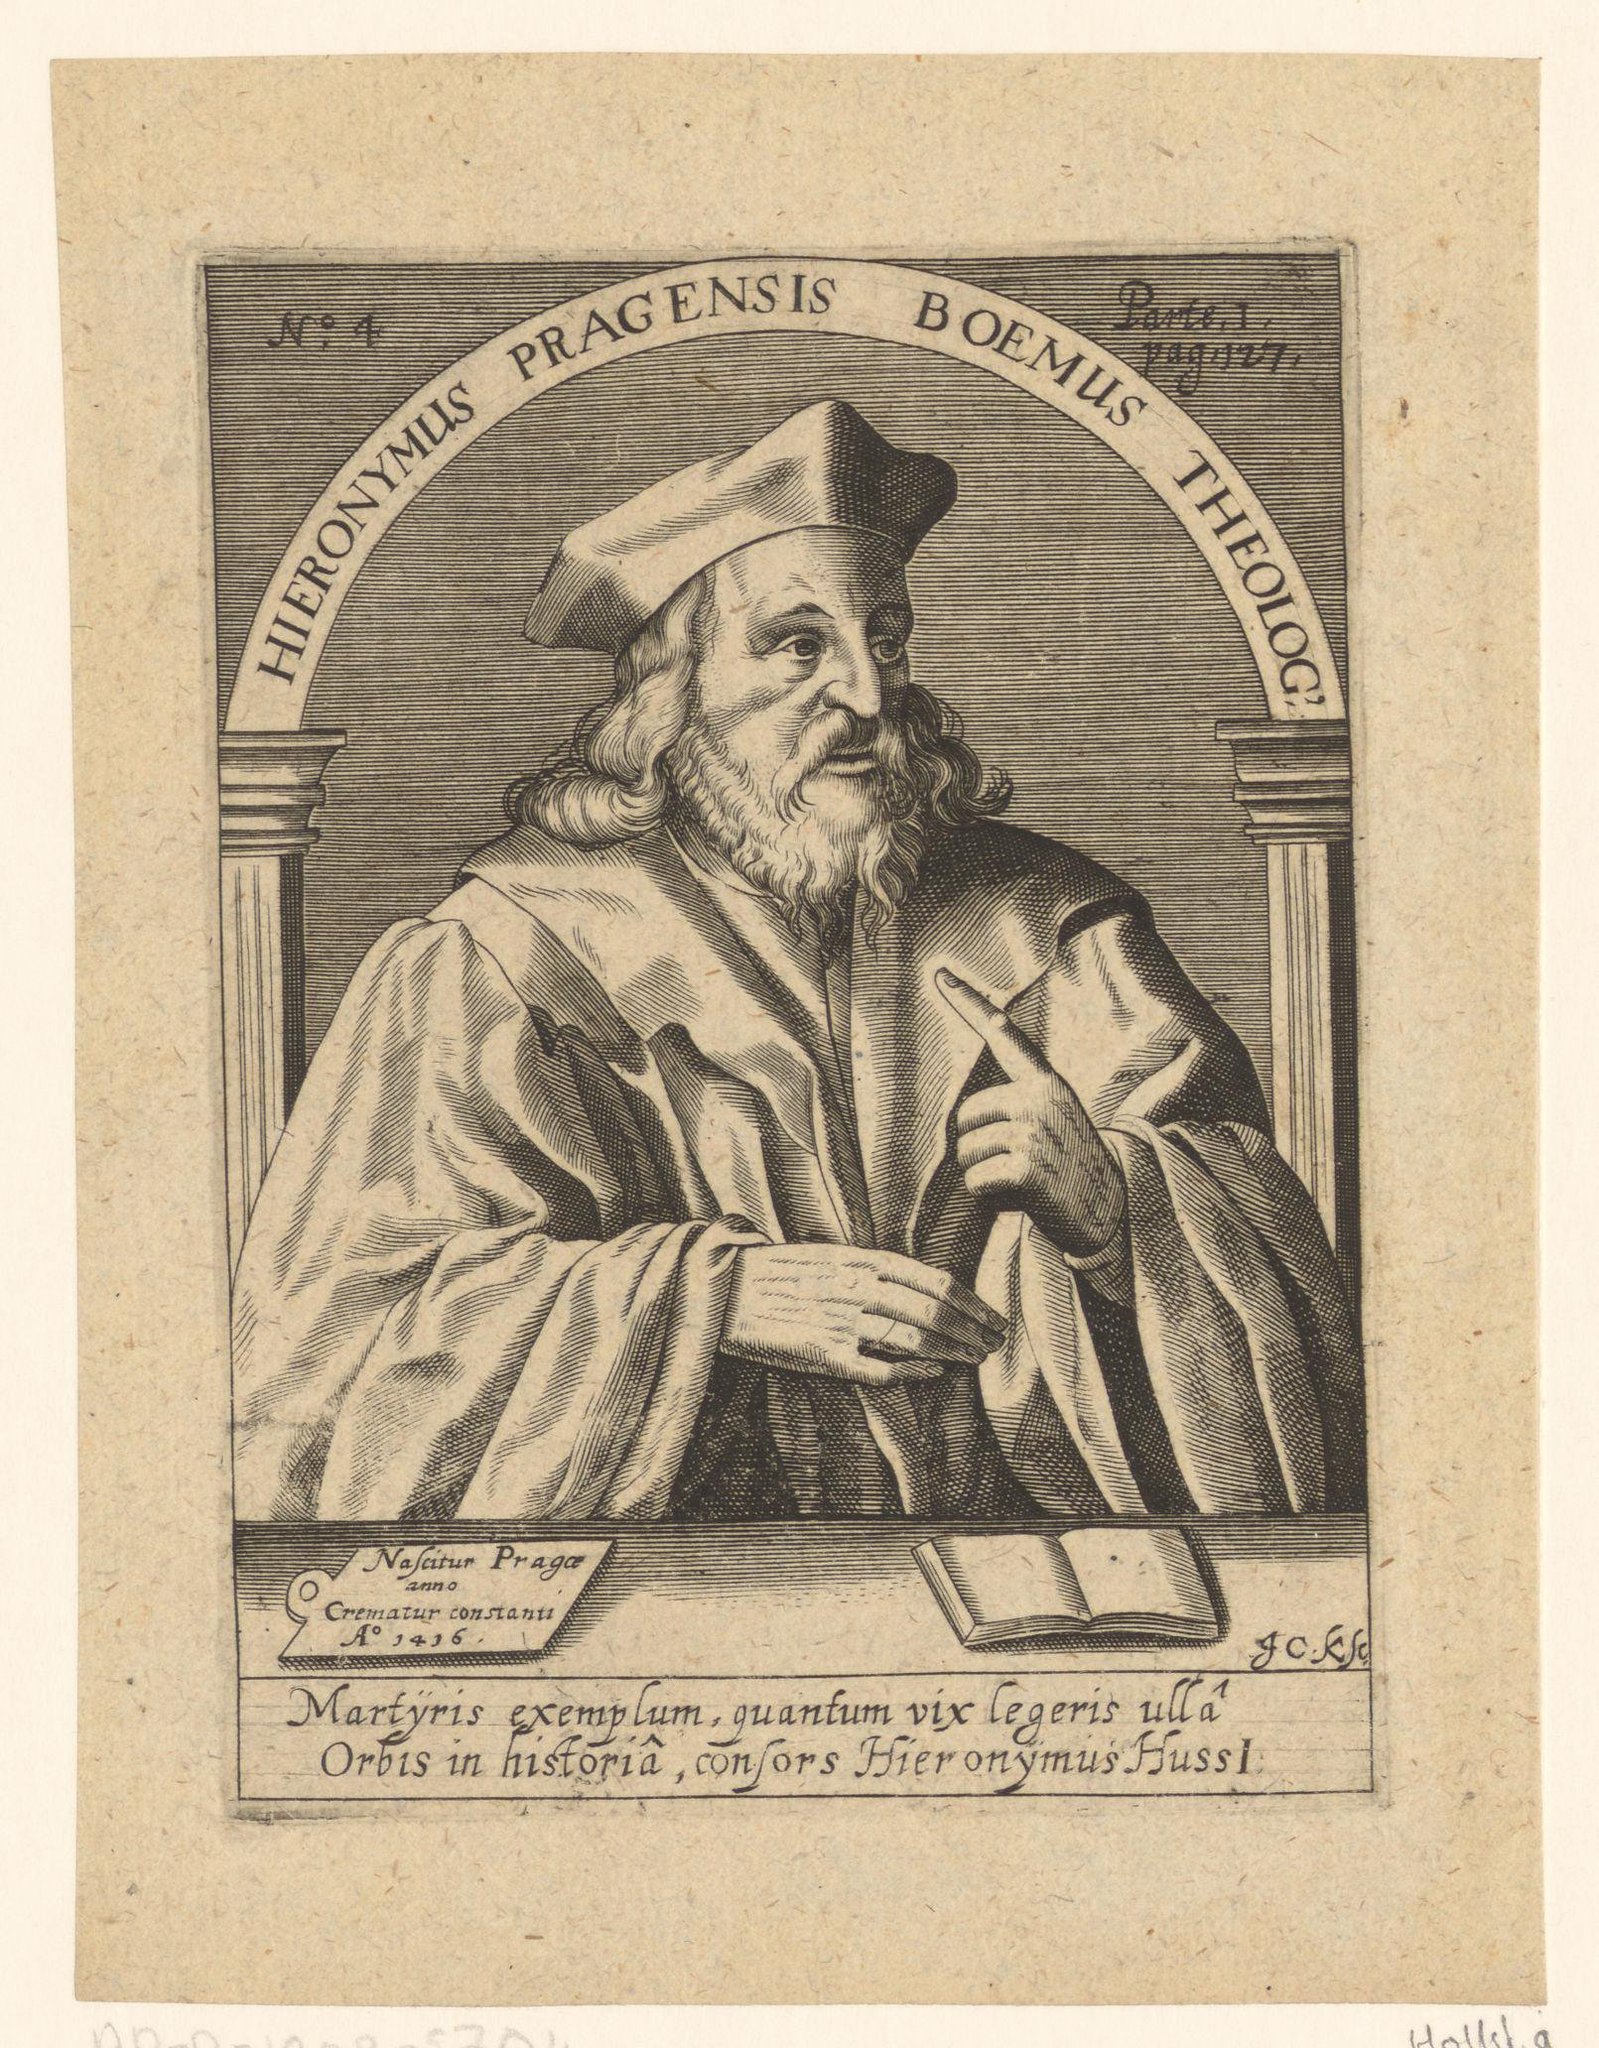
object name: print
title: Portret van Hiëronymus van Praag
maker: johann conrad klüpfel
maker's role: print maker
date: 1621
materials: paper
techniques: engraving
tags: theologian, scholar, philosopher, historical persons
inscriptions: collector's mark: Lugt 2228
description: Dit is een van de veertien prenten door Johann Conrad Klüpfel, gebruikt in: Theobald, Zacharias. Bellum hussiticum. Frankfurt: s.n., 1621.